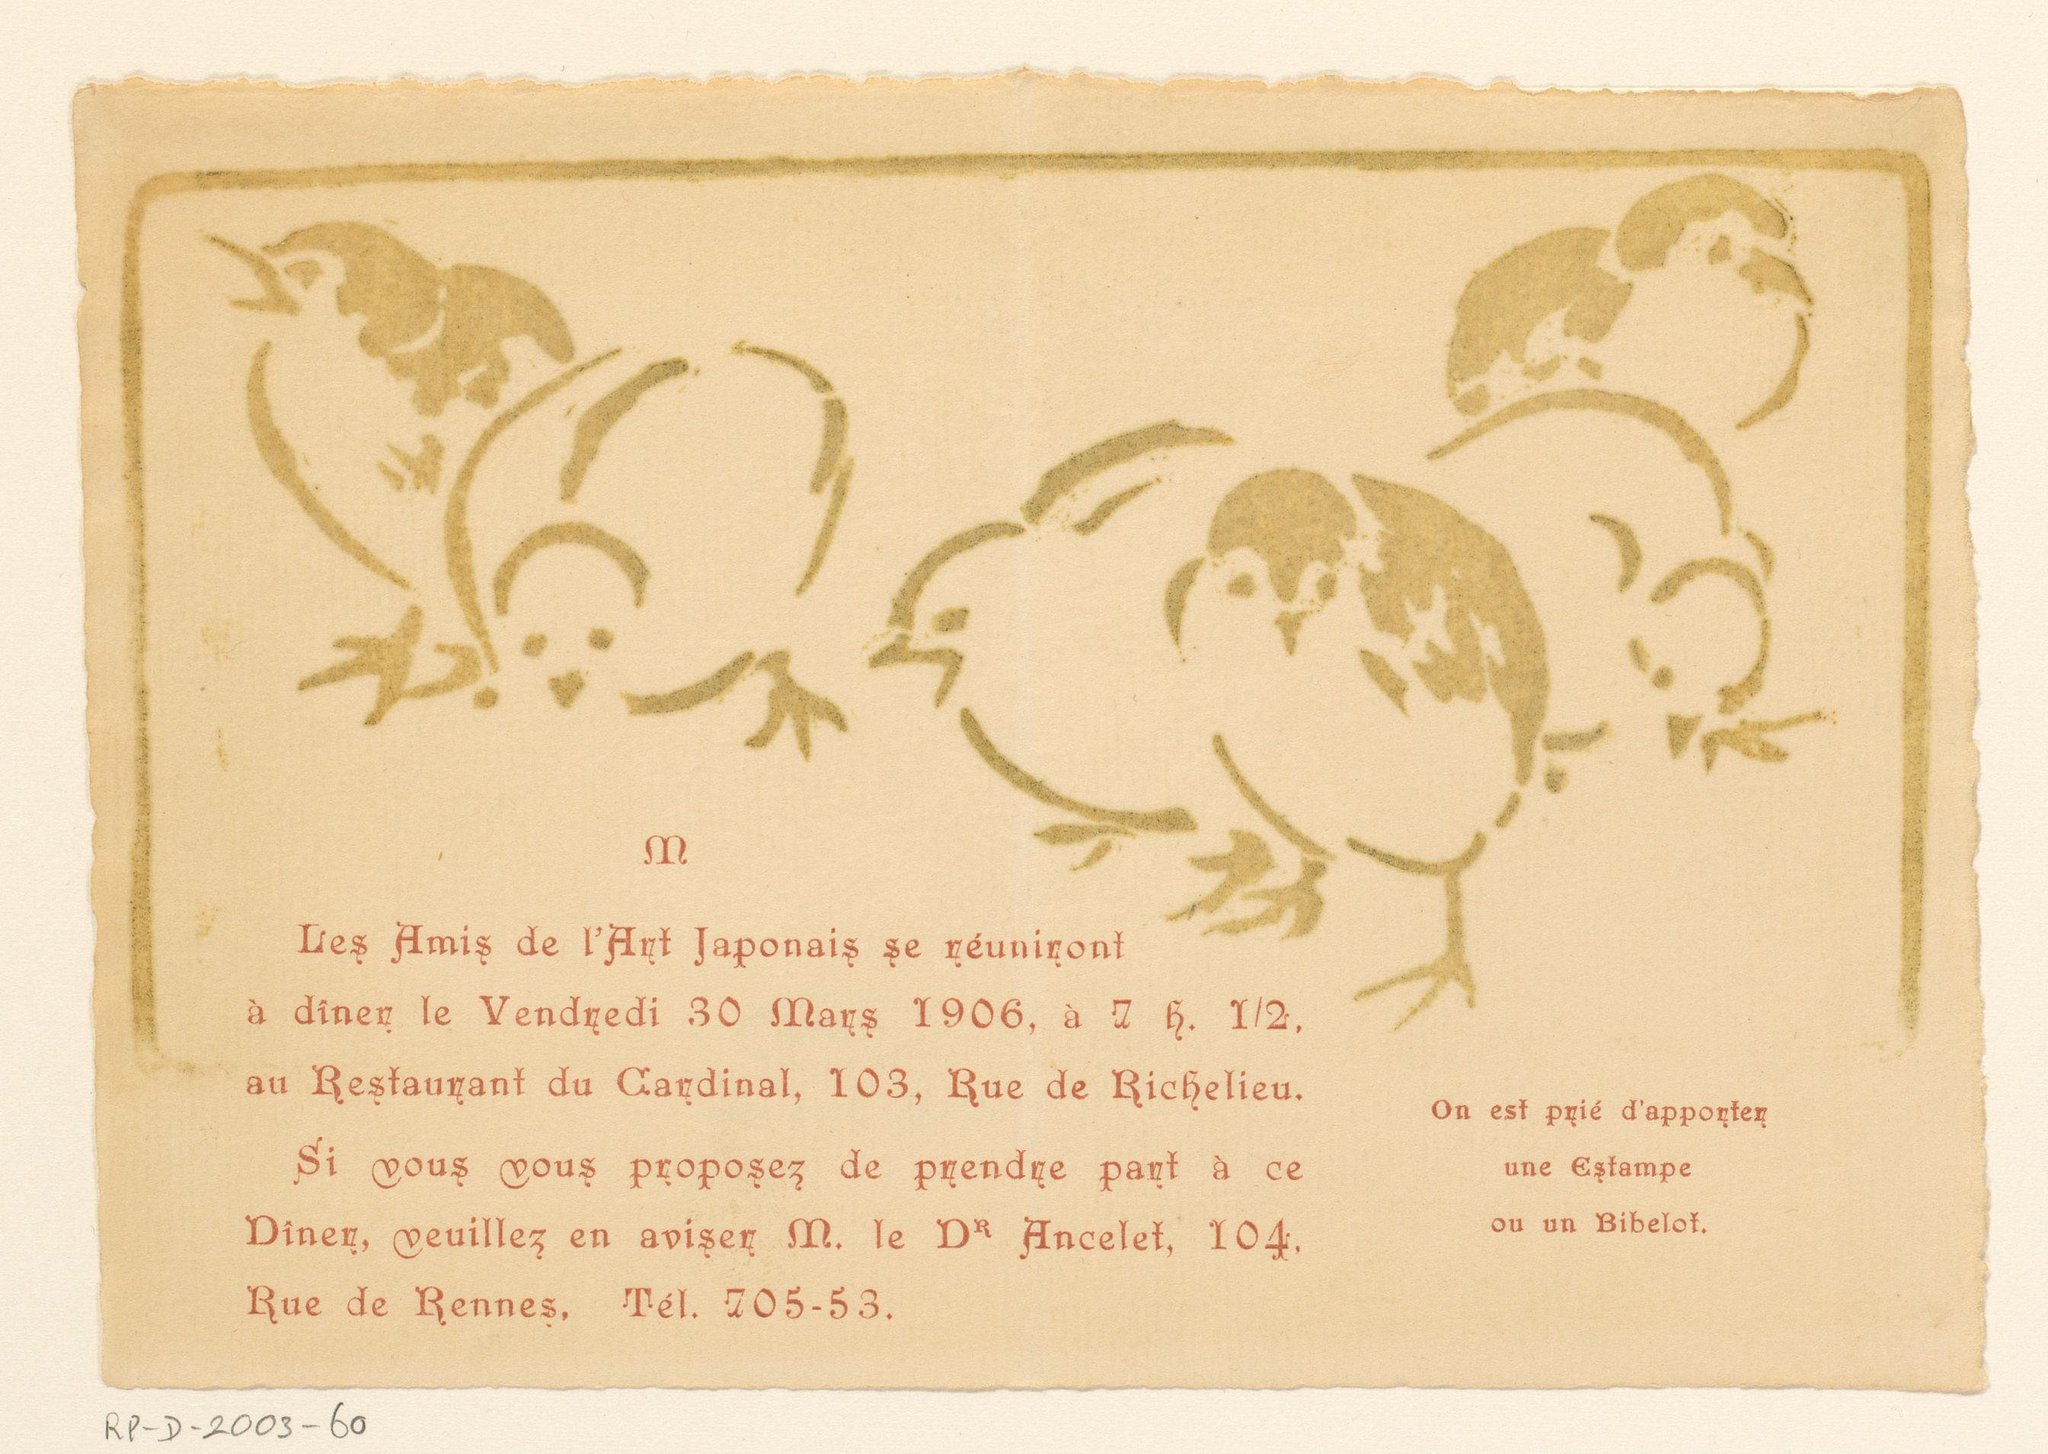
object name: invitation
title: Uitnodiging voor een diner van Les Amis de l'Art Japonais, 30 maart 1906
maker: Anonymous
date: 1903-1906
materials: paper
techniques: woodcut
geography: france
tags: fowl (cock, hen, chicken, etc.)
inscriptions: collector's mark: Lugt 2228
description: Kuikens. Uitnodiging voor een diner van Les Amis de l'Art Japonais, 30 maart 1906.